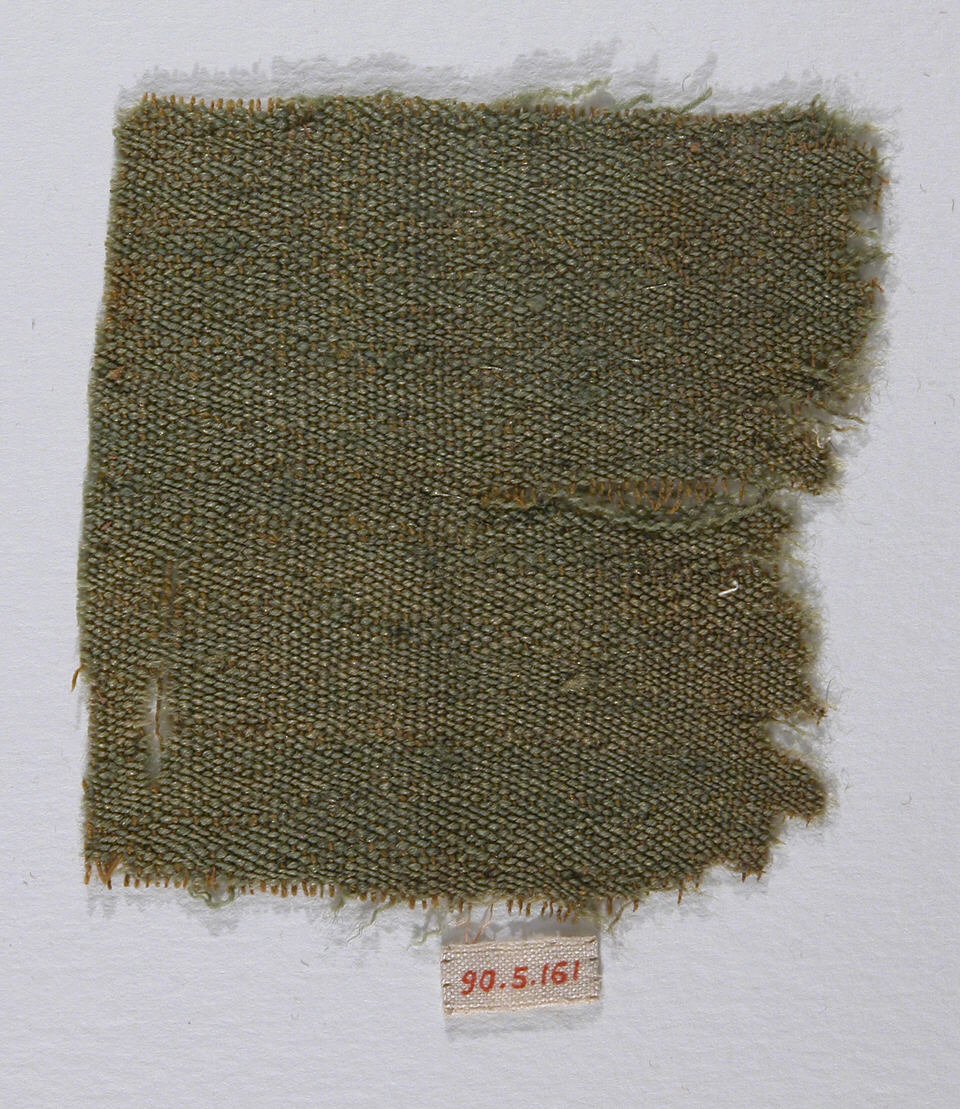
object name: textile fragment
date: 1-200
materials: wool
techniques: weave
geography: egypt